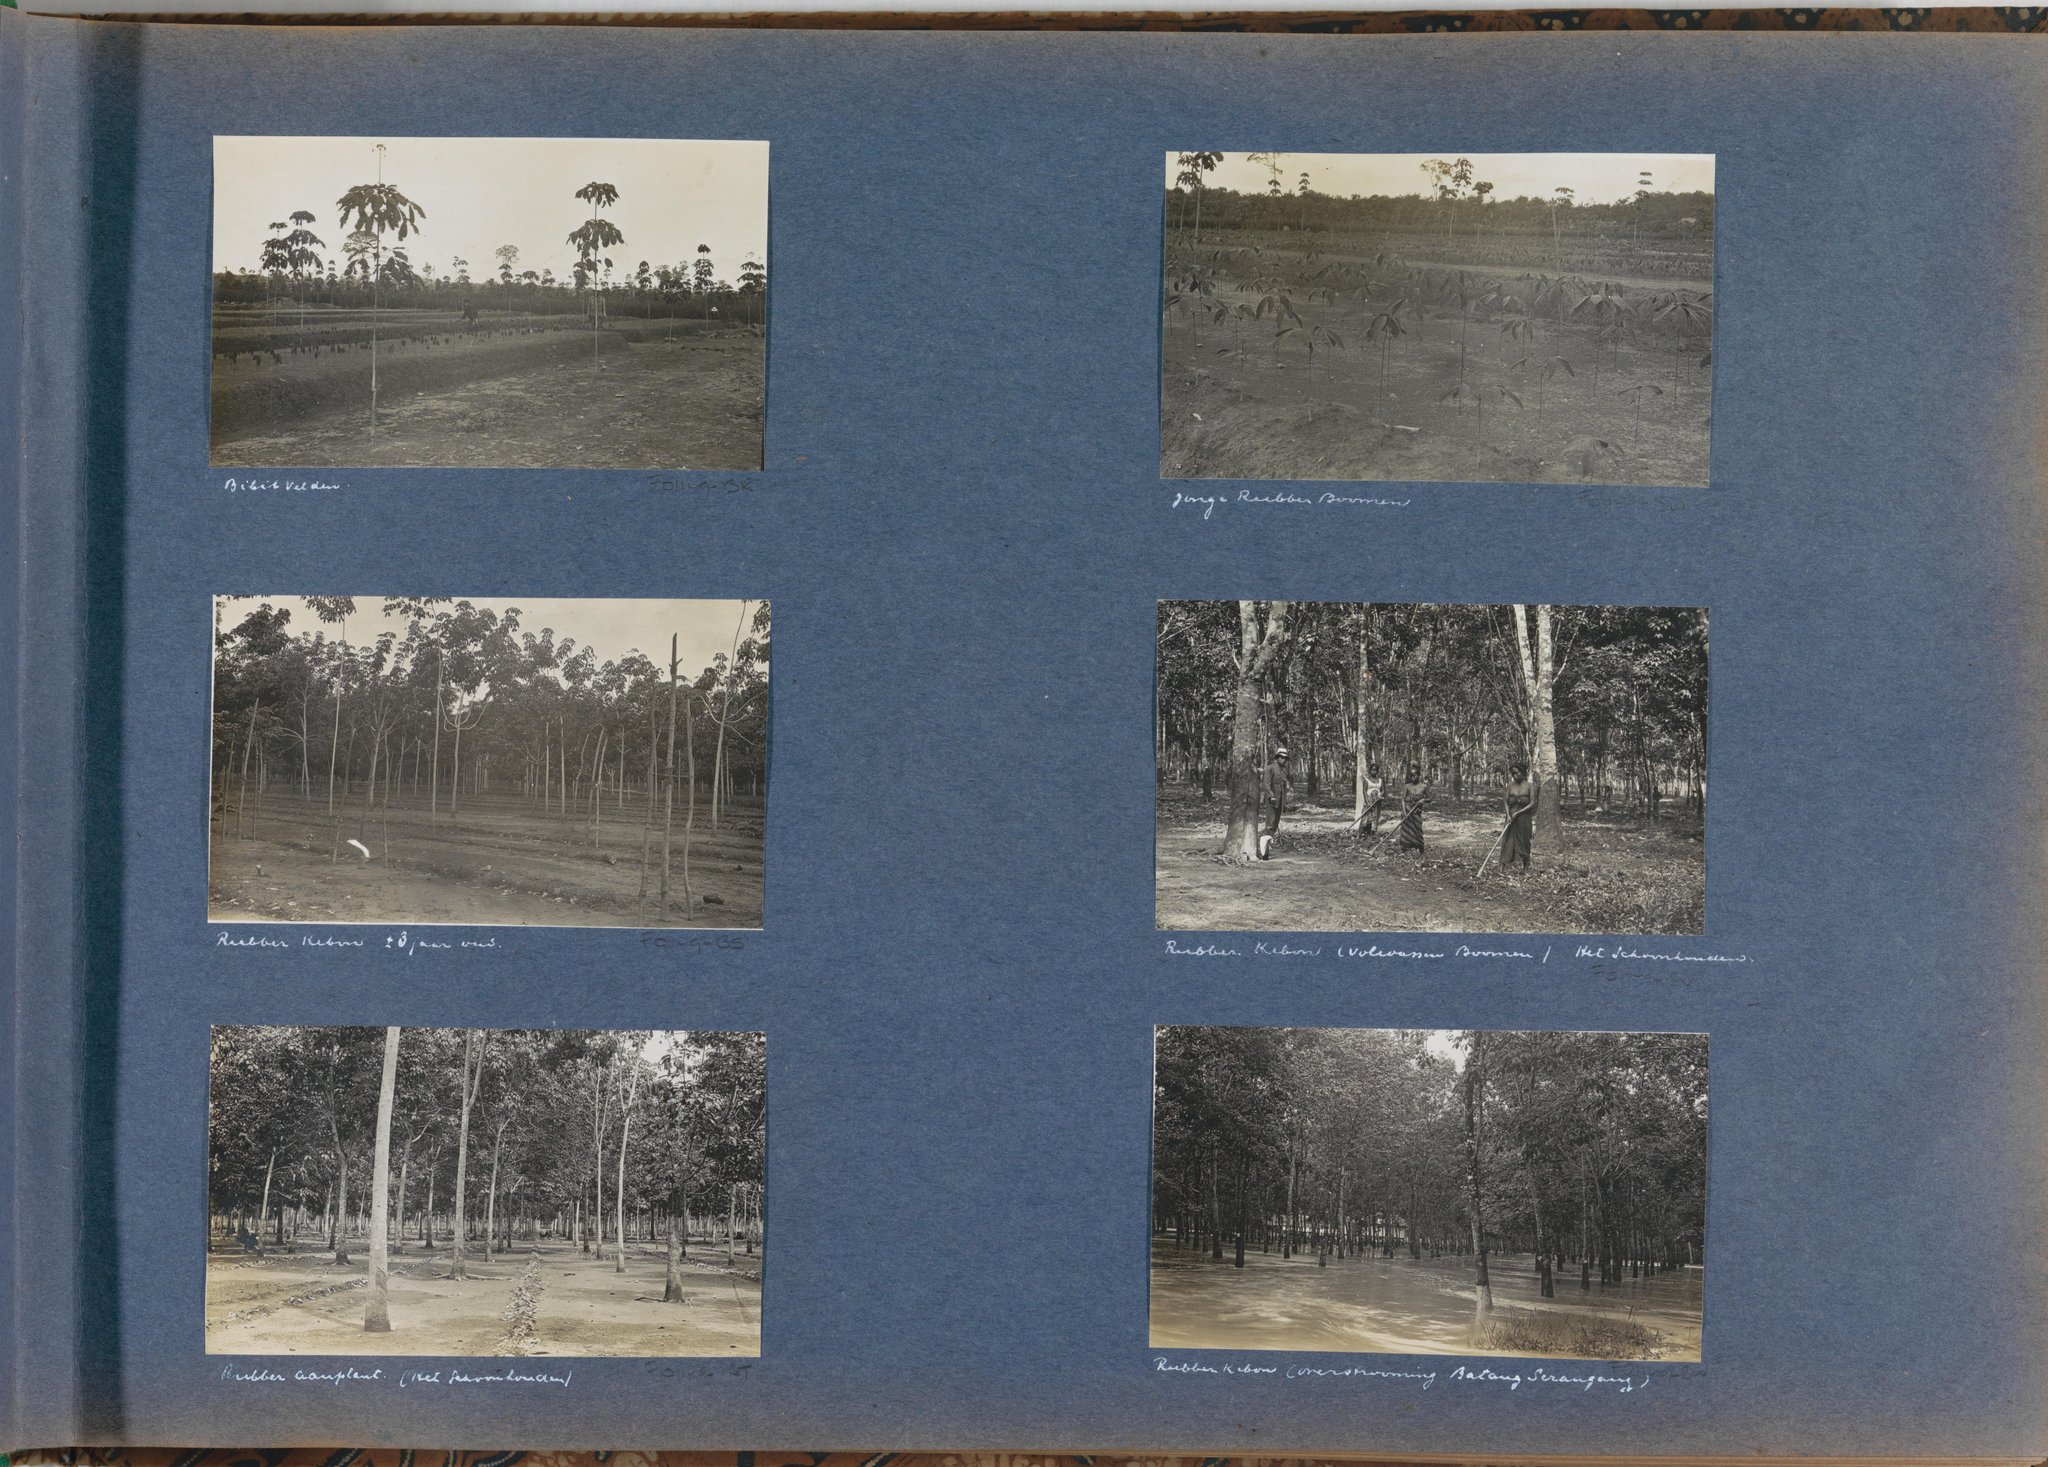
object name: photograph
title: Bedden met kiemplanten (bibit) op een rubberplantage op Sumatra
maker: Anonymous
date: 1900-1920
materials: paper, photographic support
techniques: gelatin silver print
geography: sumatra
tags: plantation, (non-fruit) products of plants or trees: rubber, sumatra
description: Onderdeel van reisalbum met foto's van bedrijvigheid en bezienswaardigheden op Sumatra en Java en van de reis naar en van Nederlands-Indië.